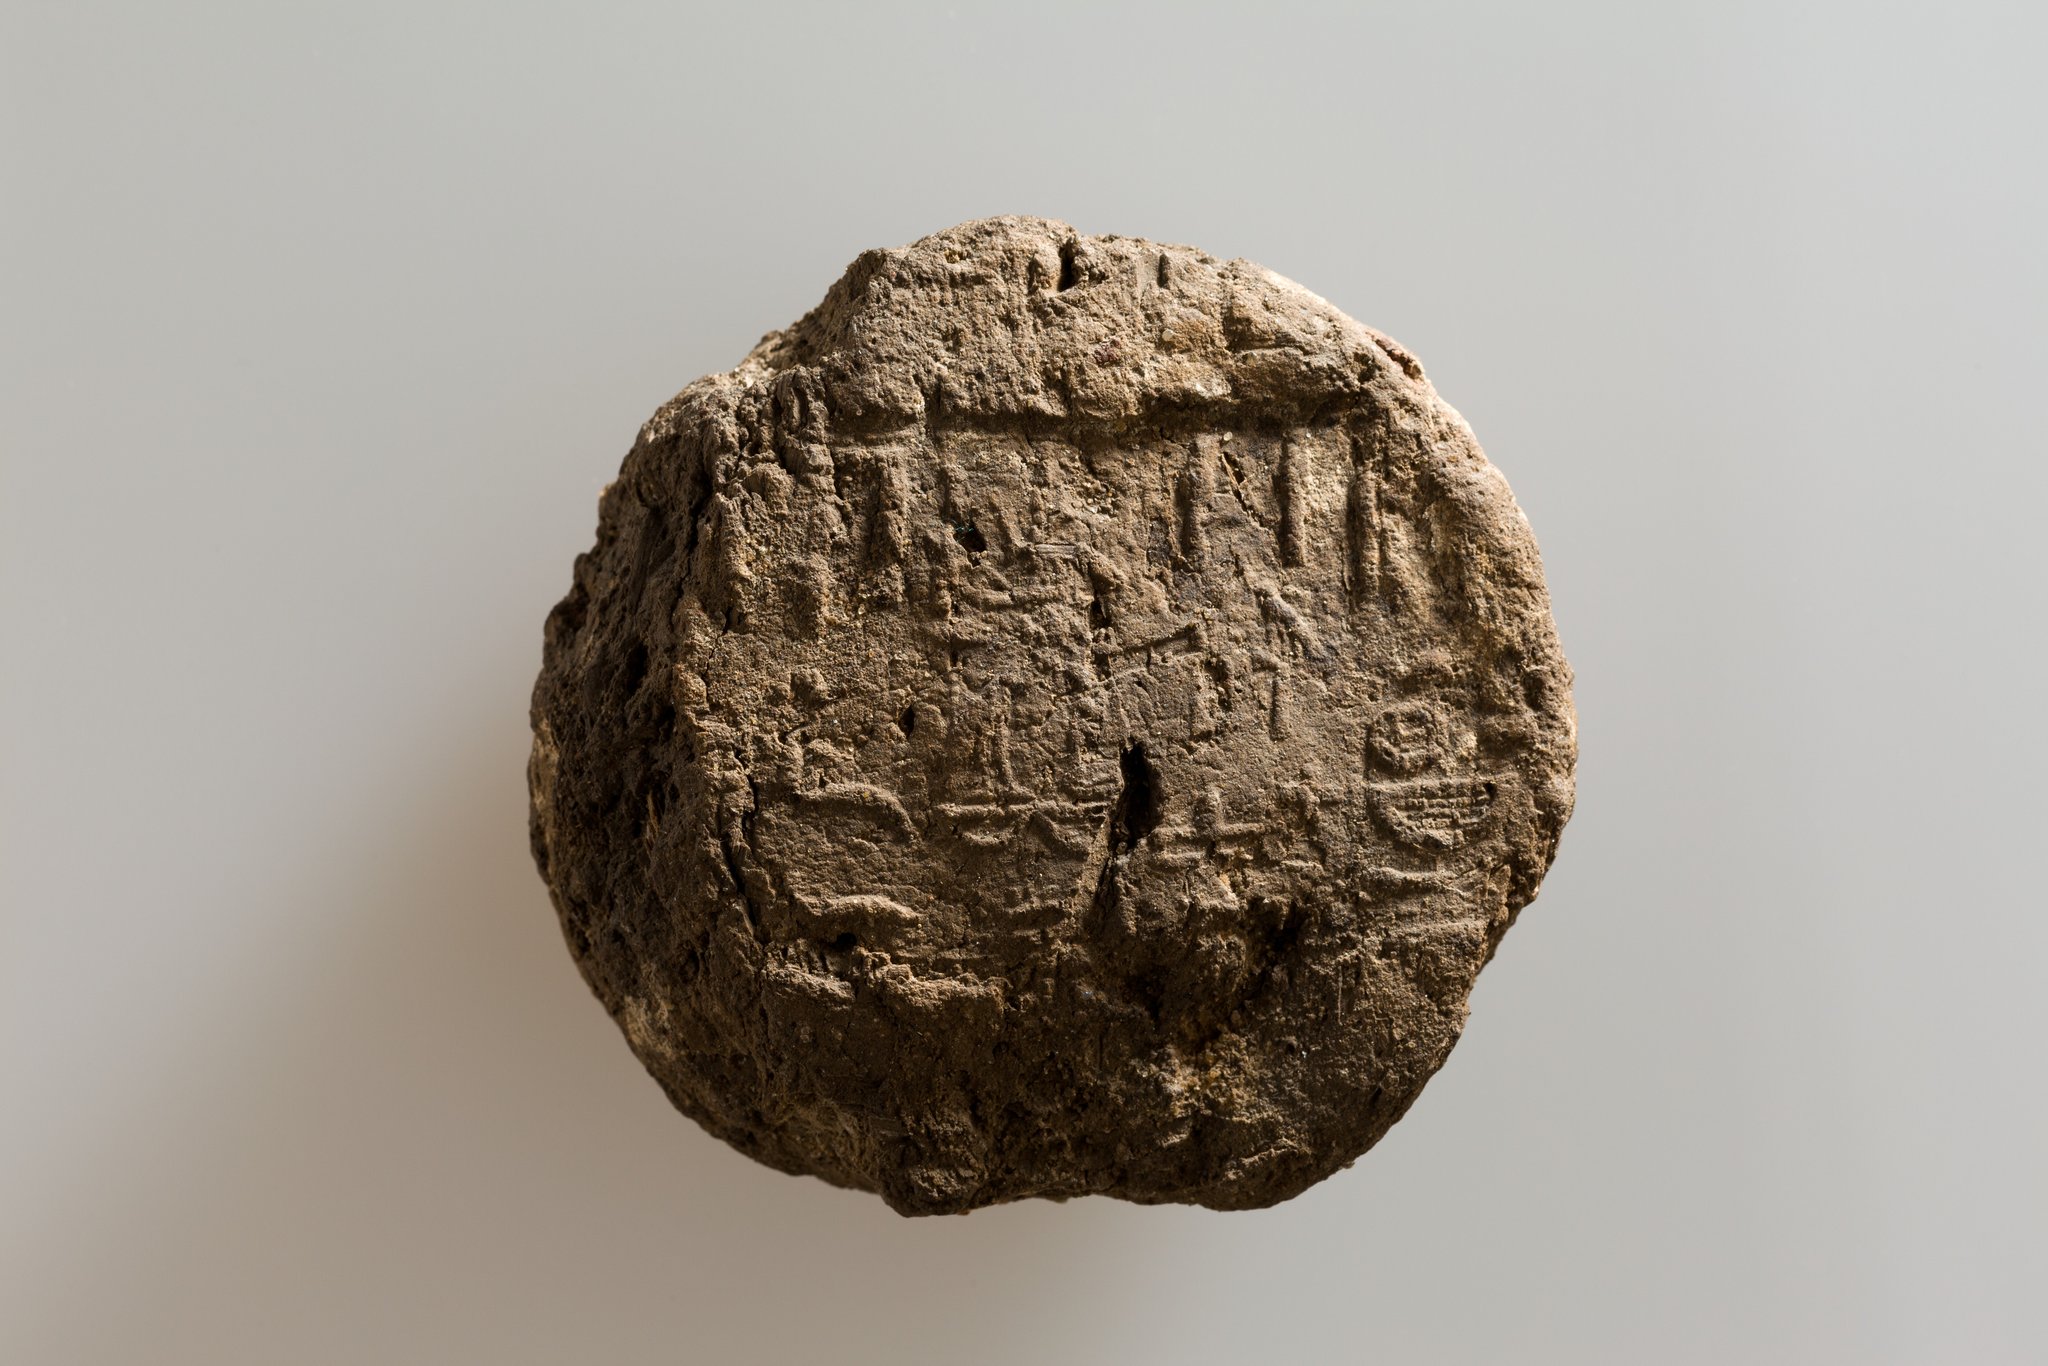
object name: sealing, jar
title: Clay jar sealing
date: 2650 BCE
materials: clay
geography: egypt